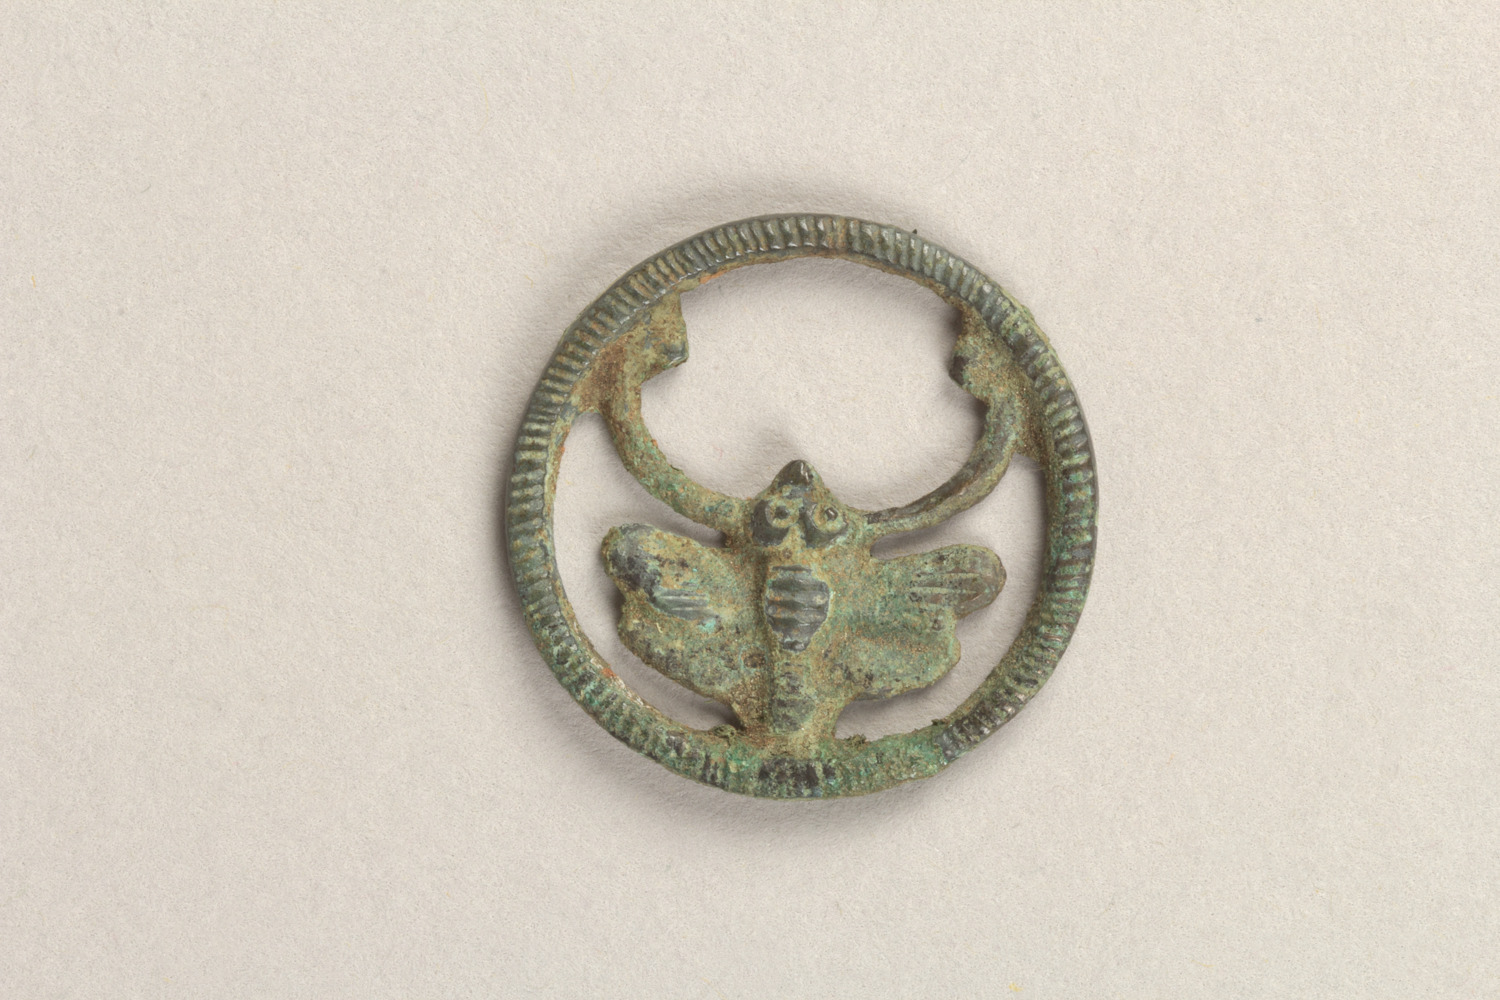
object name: ornament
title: Ornament with insect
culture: korean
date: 918-1392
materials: bronze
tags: insects